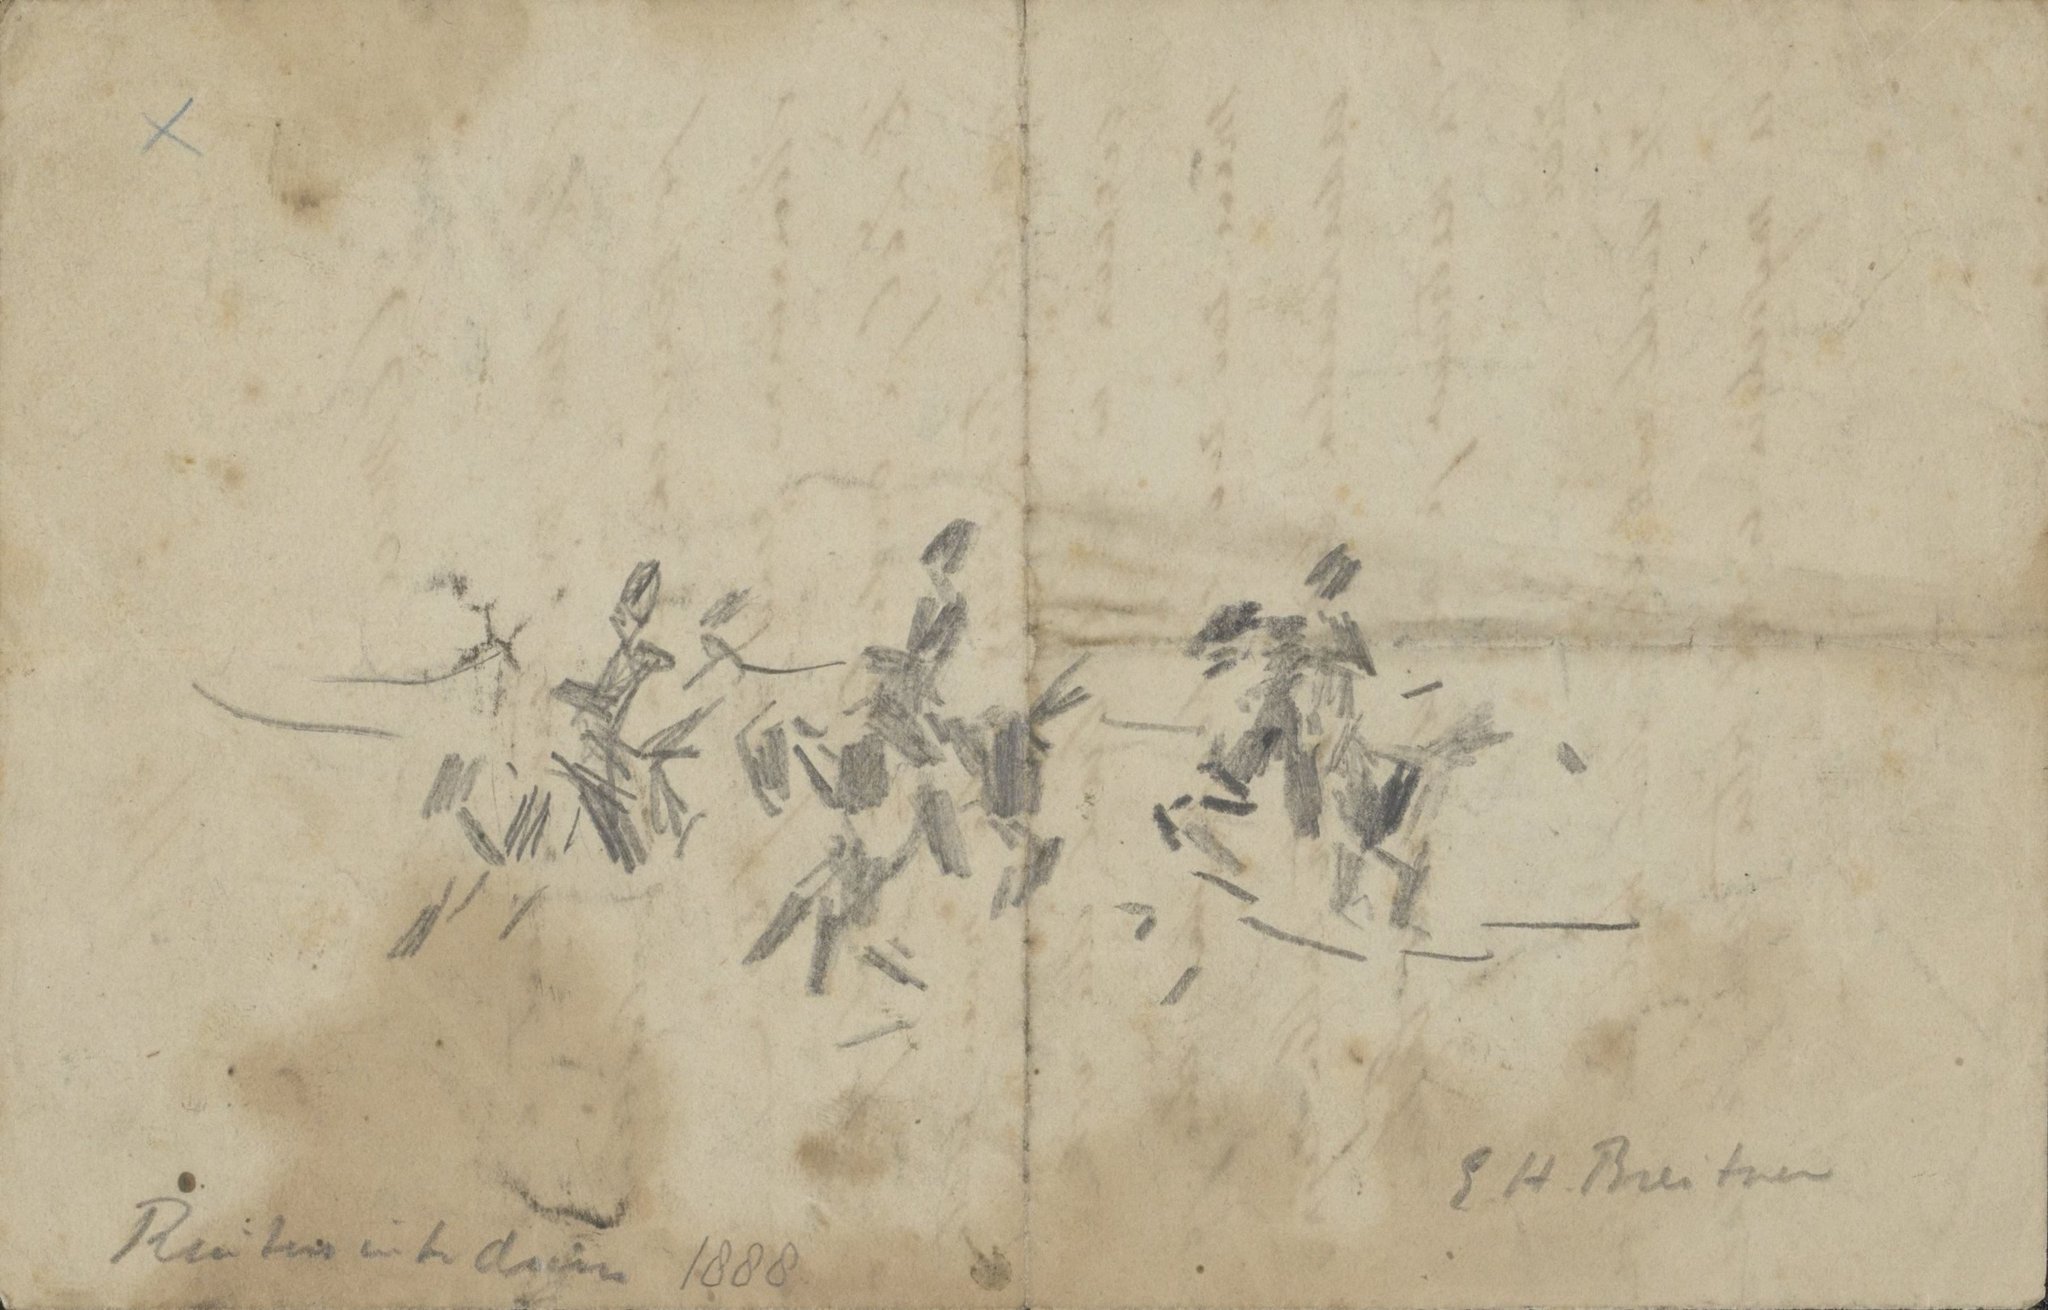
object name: letter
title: Ruiters in de duinen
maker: george hendrik breitner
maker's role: draughtsman, painter, print maker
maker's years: 1857-1923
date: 1888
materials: paper, pencil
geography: the hague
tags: land forces (+ cavalry, horsemen), dunes (sea not visible); in the dunes (+ landscape with figures, staffage)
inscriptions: annotation: ‘Ruiters in de duinen’, signature: ‘G.H. Breitner’, workshop stamp: Lugt 291d, collector's mark: Lugt 2228, annotation: ‘27/3 1888/ Amice,/ Ik heb gisteren niet aan/ je verzoek kunnen voldoen./ [...]’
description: Verso een brief van E.J. van Wisselingh, kunsthandelaar te Den Haag.